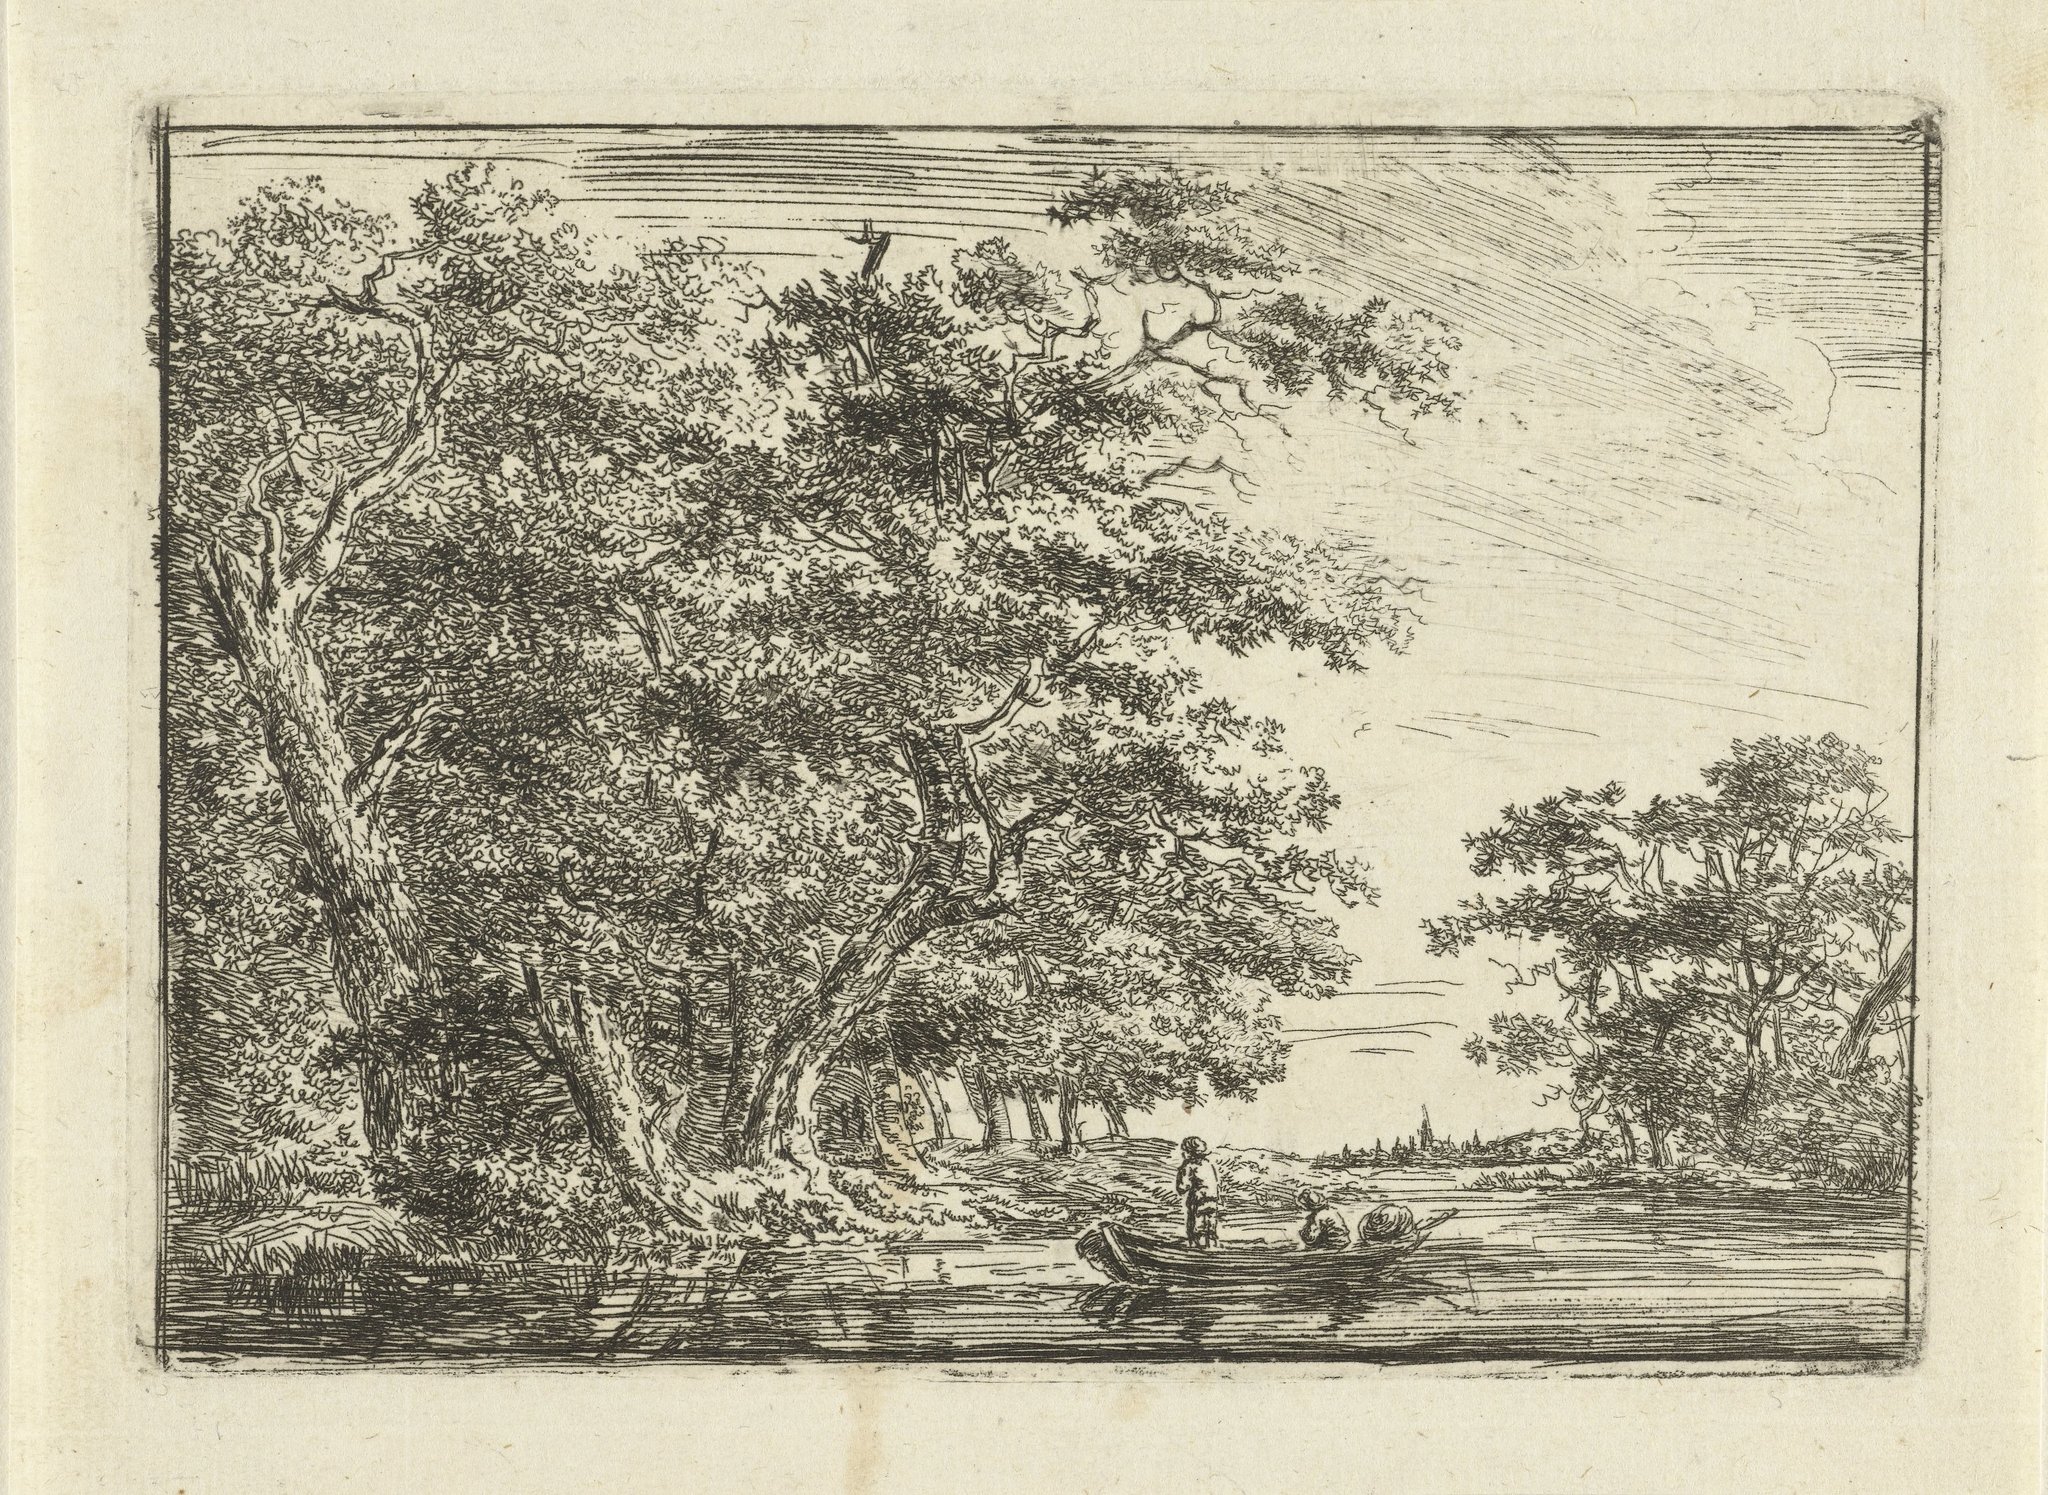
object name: print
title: Vissers in bootje aan bosrijke oever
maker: hermanus van brussel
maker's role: draughtsman, print maker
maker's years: 1763-1815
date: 1800-1815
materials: paper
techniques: drypoint, etching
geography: netherlands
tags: landscapes with waters, waterscapes, seascapes (in the temperate zone)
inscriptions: collector's mark: Lugt 2228